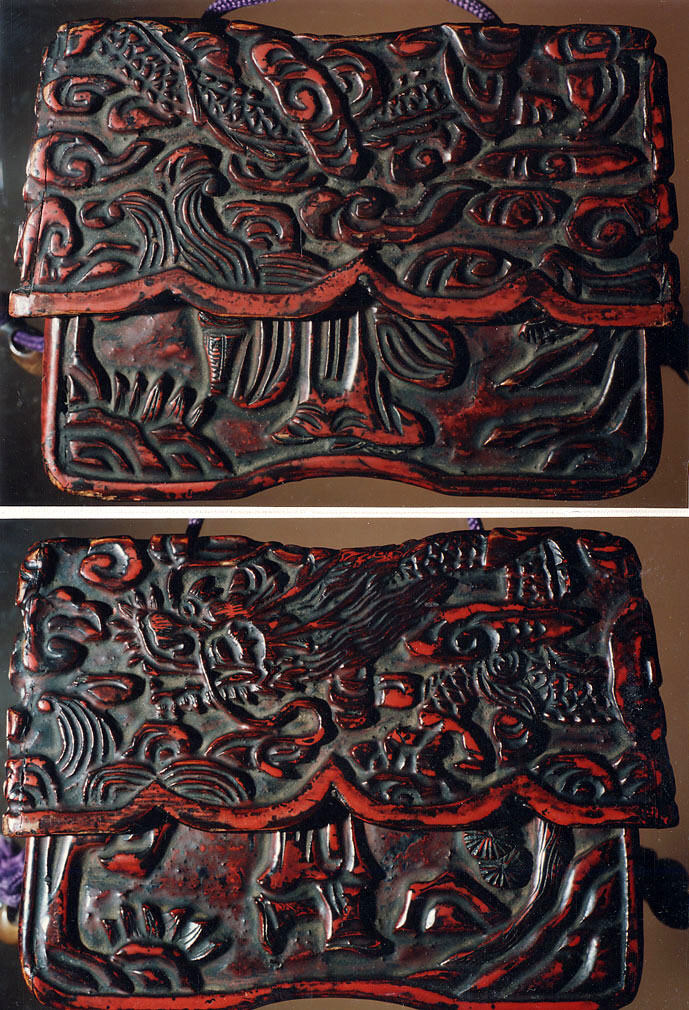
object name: inrō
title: Case (Inrō) with Design of Chinese Sages in Mountain Landscape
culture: japanese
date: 1850-1880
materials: lacquer, wood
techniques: carving, roiro